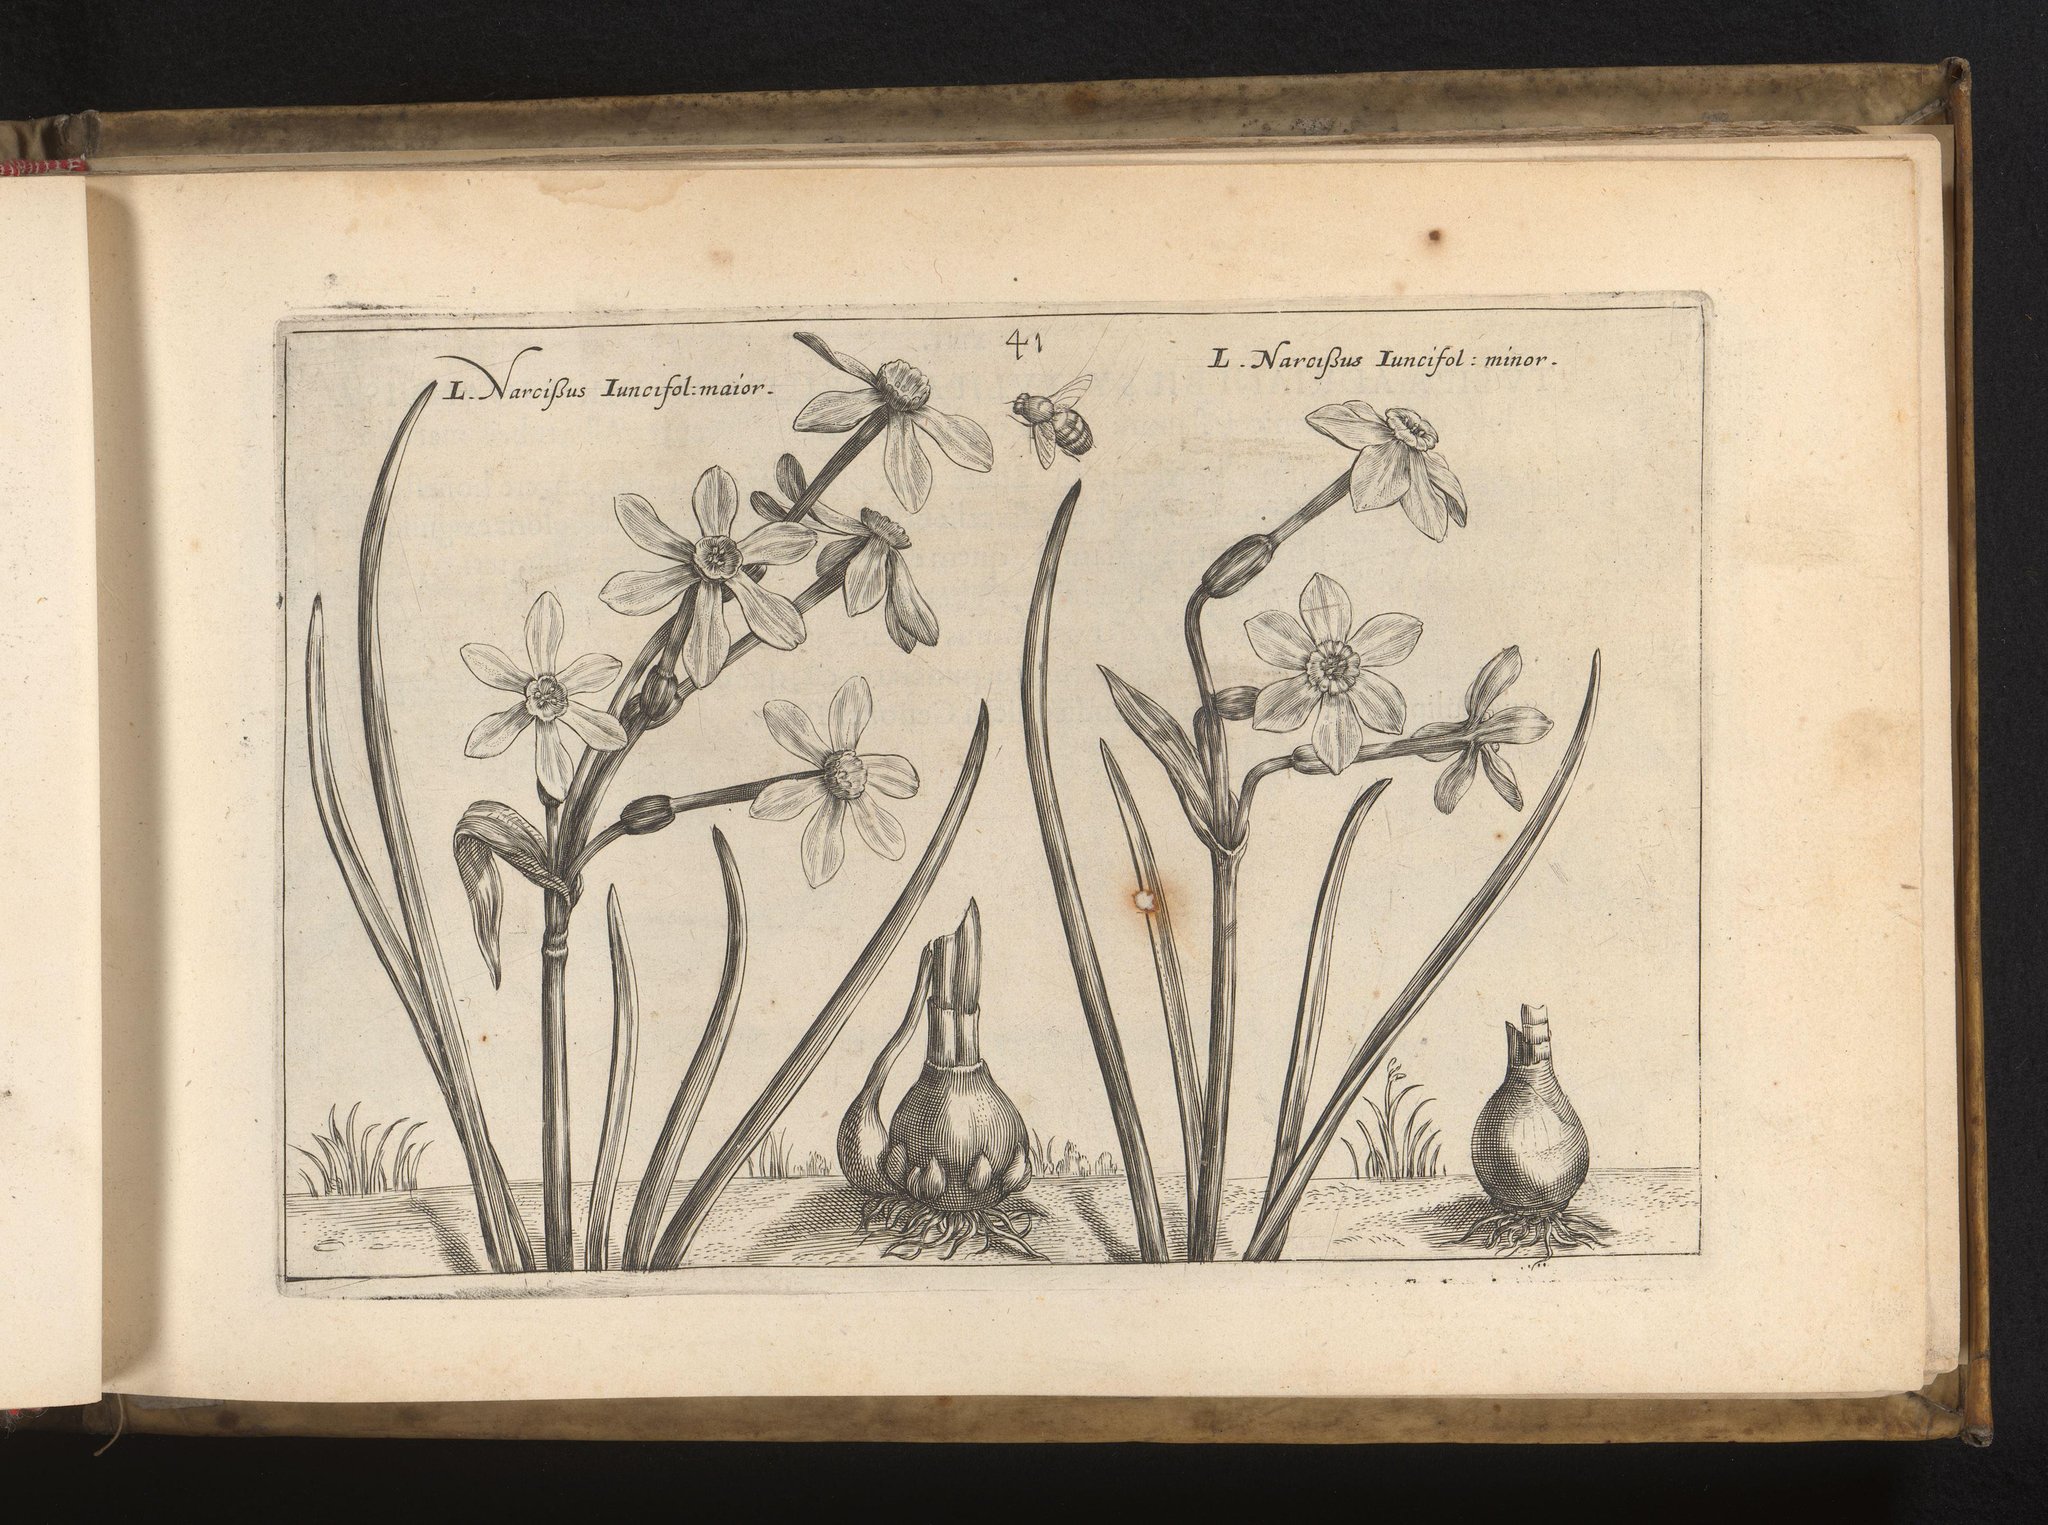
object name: book illustration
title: Narcissus iuncifol. major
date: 1617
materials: paper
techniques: engraving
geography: utrecht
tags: flowers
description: Prent uit: Passe, Crispijn van de (II). Hortus floridus in quo rariorum & minus vulgarium florum icones ad vivam veramque formam. Arnhem: Johannes Janssonius, 1617.